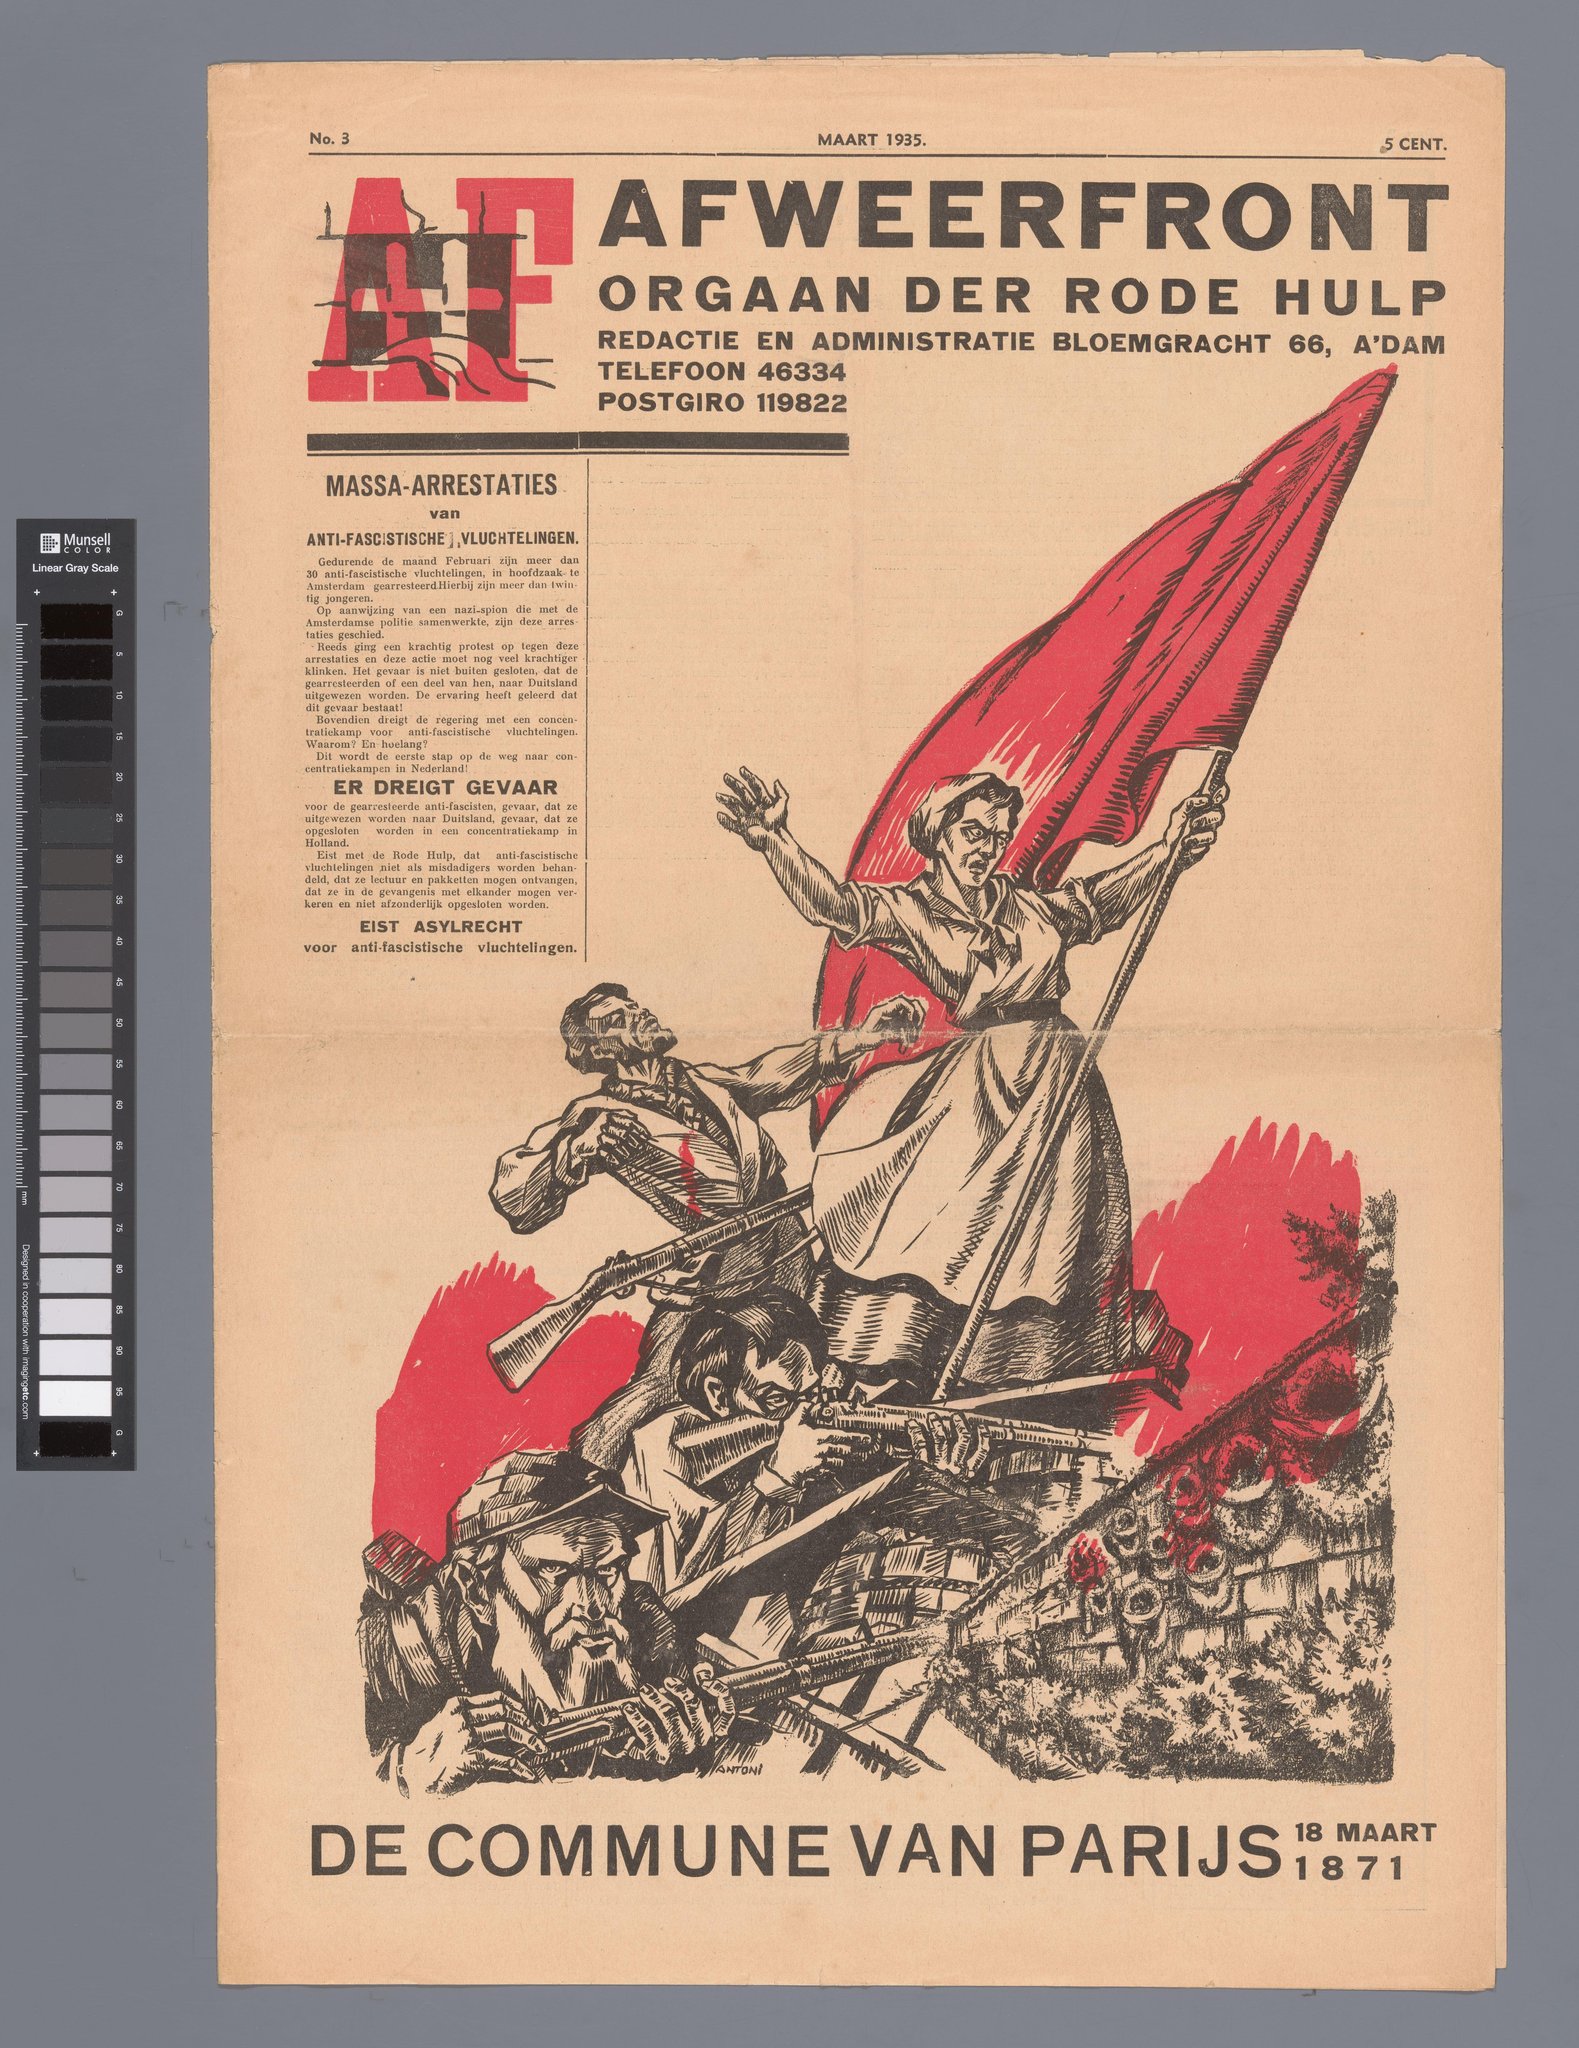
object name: newspaper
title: Afweerfront; orgaan der rode hulp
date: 1903-1935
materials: paper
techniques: printing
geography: amsterdam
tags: netherlands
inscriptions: date